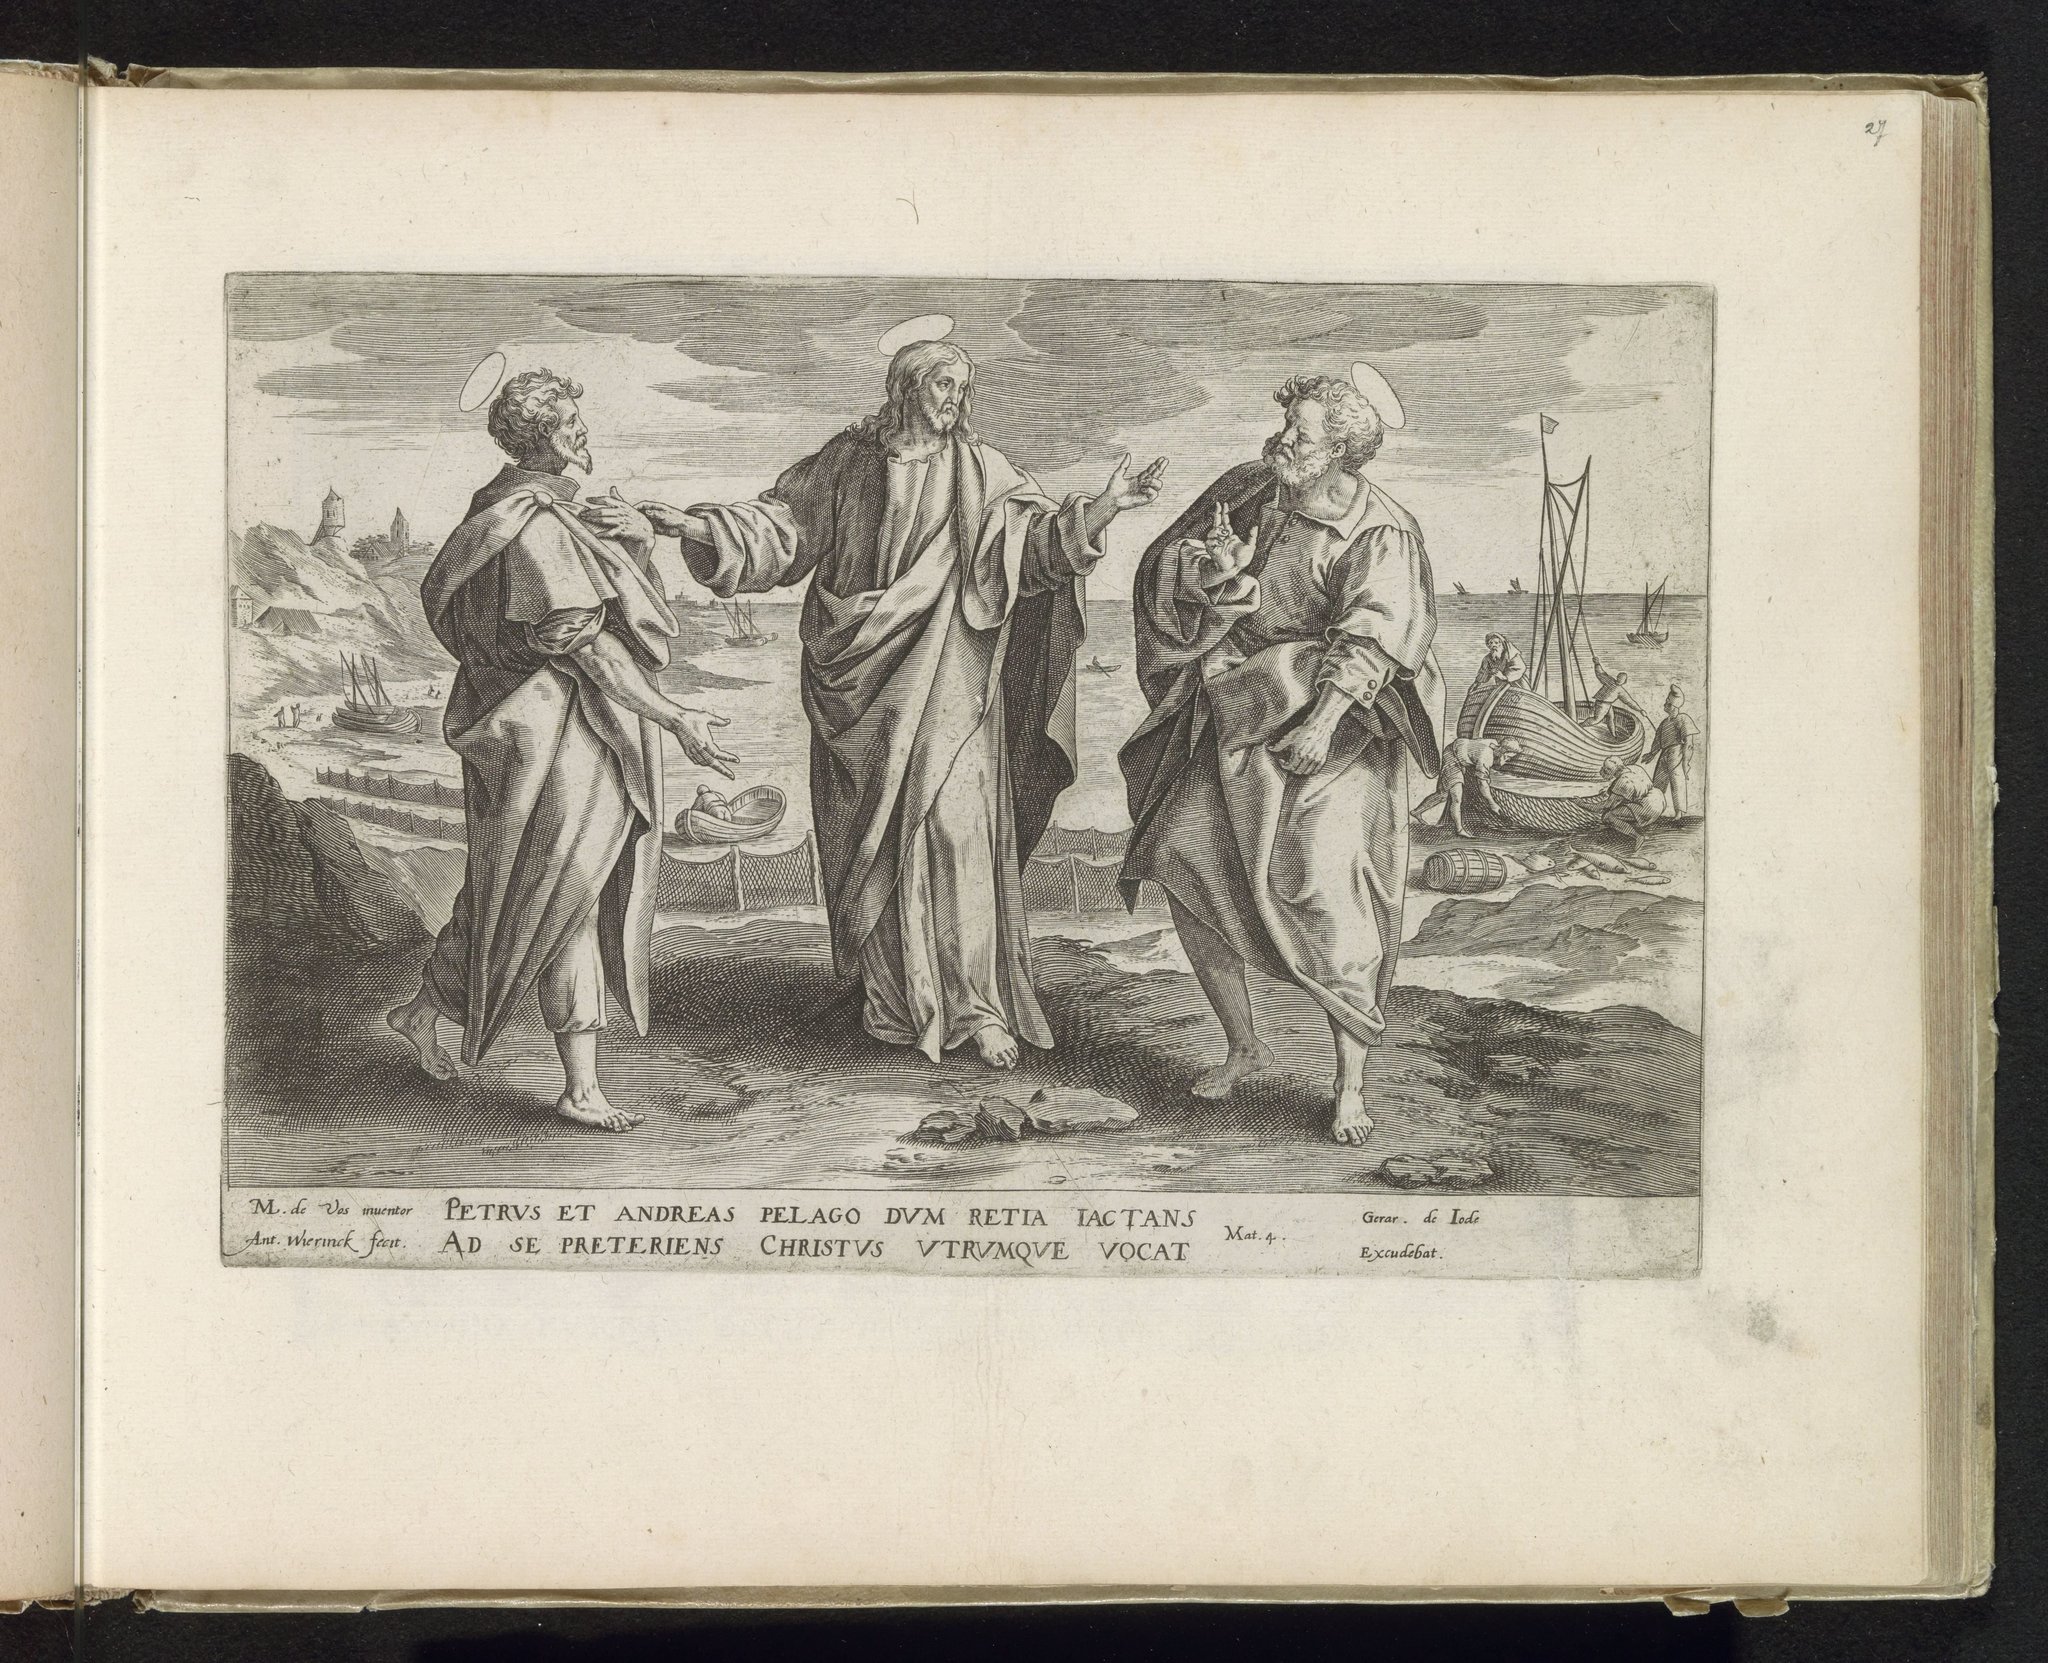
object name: print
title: Roeping van Petrus en Andreas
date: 1585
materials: paper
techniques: engraving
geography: antwerp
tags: calling of peter and andrew (john 1:40-42)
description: Christus roept Andreas en Petrus op om hem te volgen en hun vissersnetten achter te laten. Rechts op de achtergrond wat voorafging: Andreas en Petrus gooien hun netten uit in het meer. Onder de voorstelling een verwijzing in het Latijn naar de Bijbeltekst in Mat. 4. Deze prent maakt deel uit van een album.